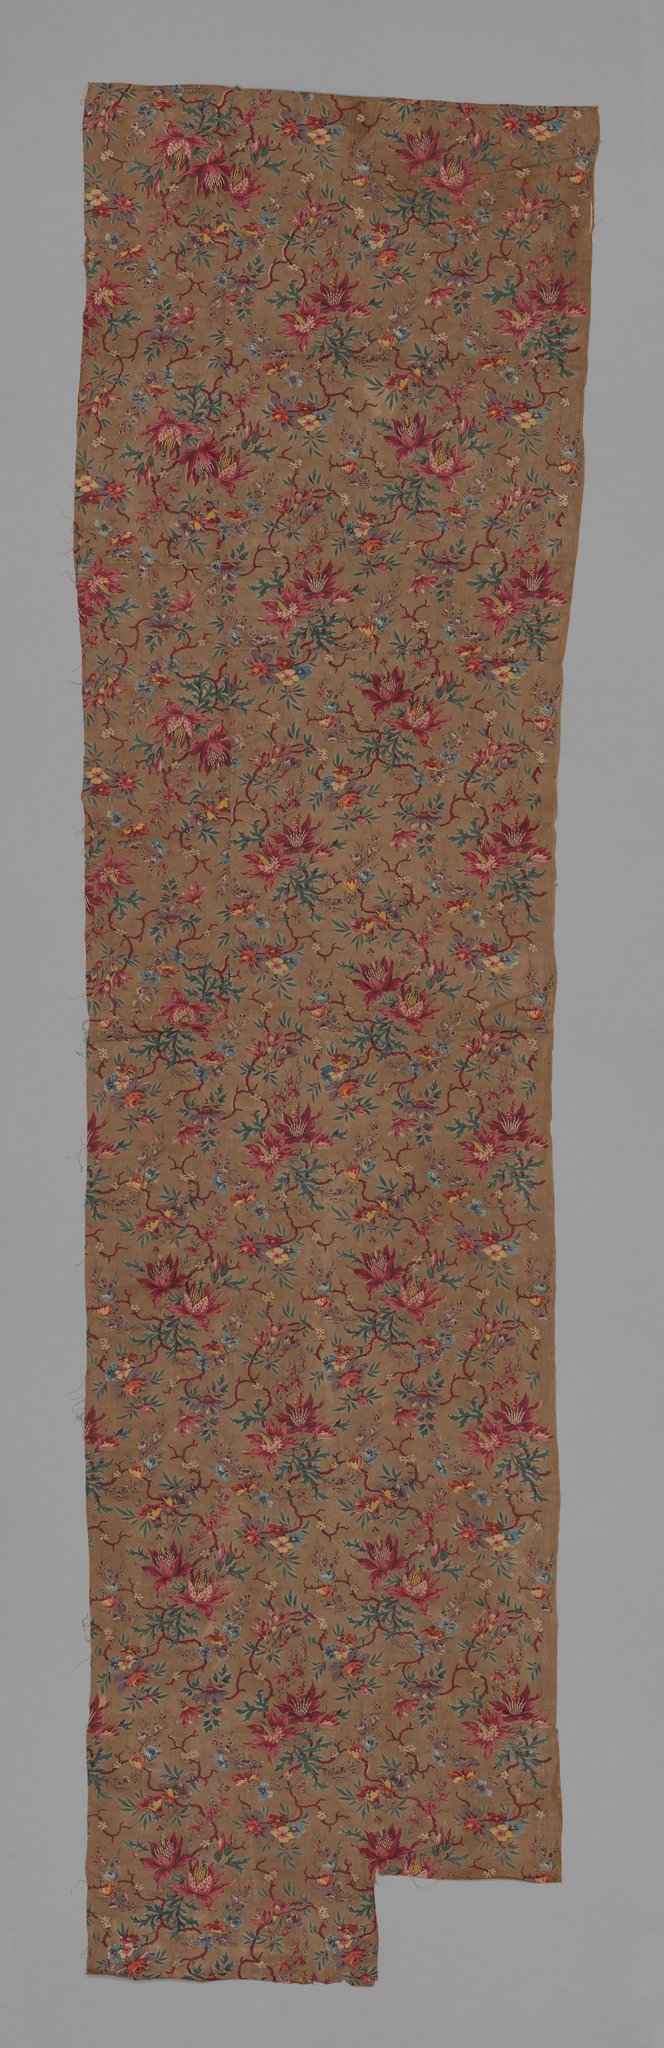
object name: length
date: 1800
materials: cotton